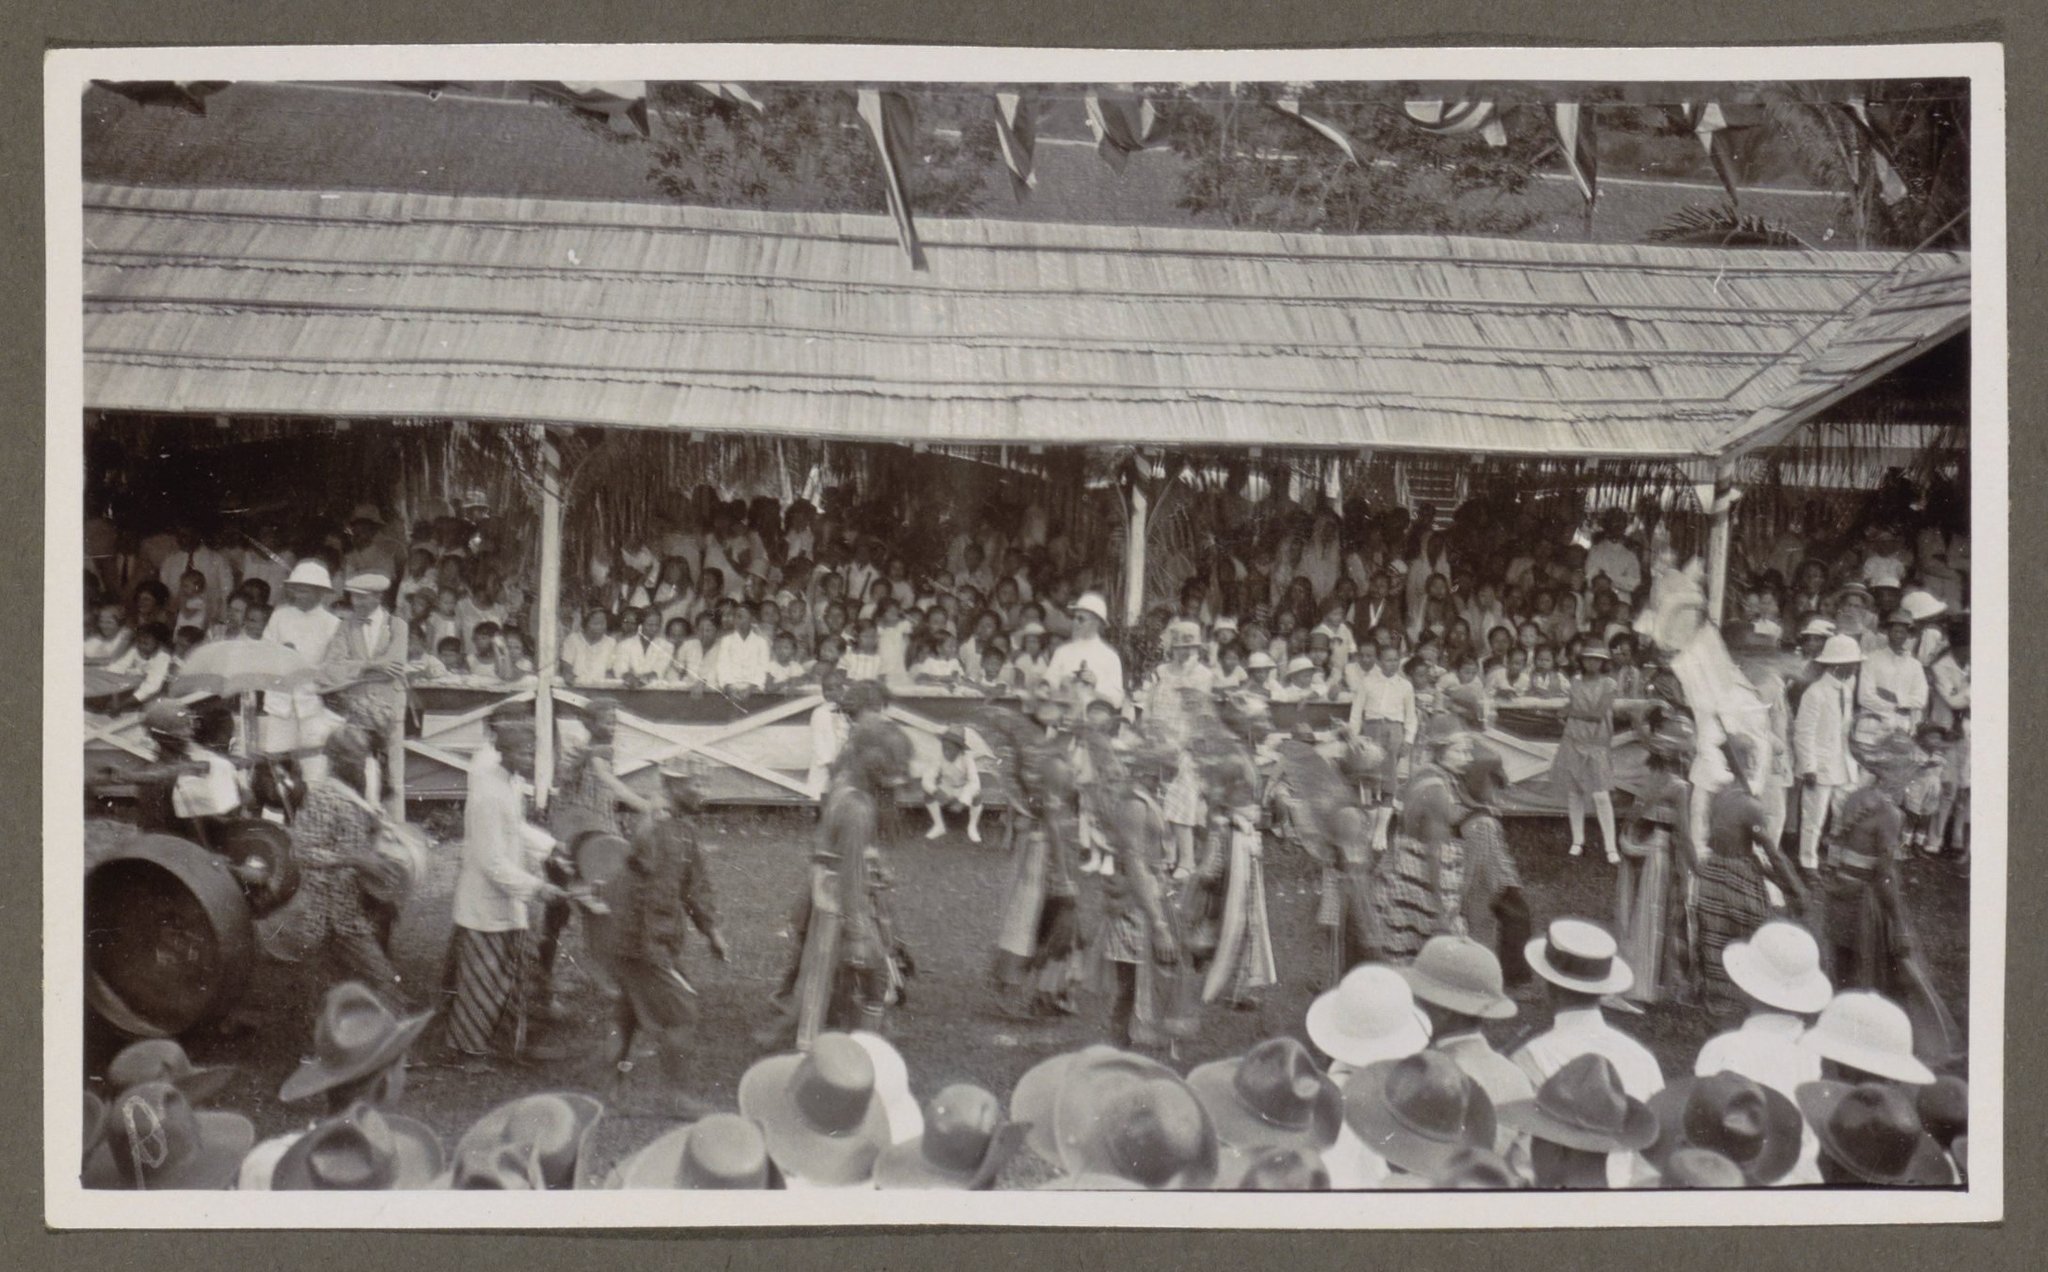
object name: photograph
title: Deelnemers aan een optocht voor een tribune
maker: Anonymous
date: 1920-1930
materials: photographic support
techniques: gelatin silver print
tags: public festivities at birth of royal persons, dutch east indies, the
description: Onderdeel van familiealbum Nederlands-Indië.